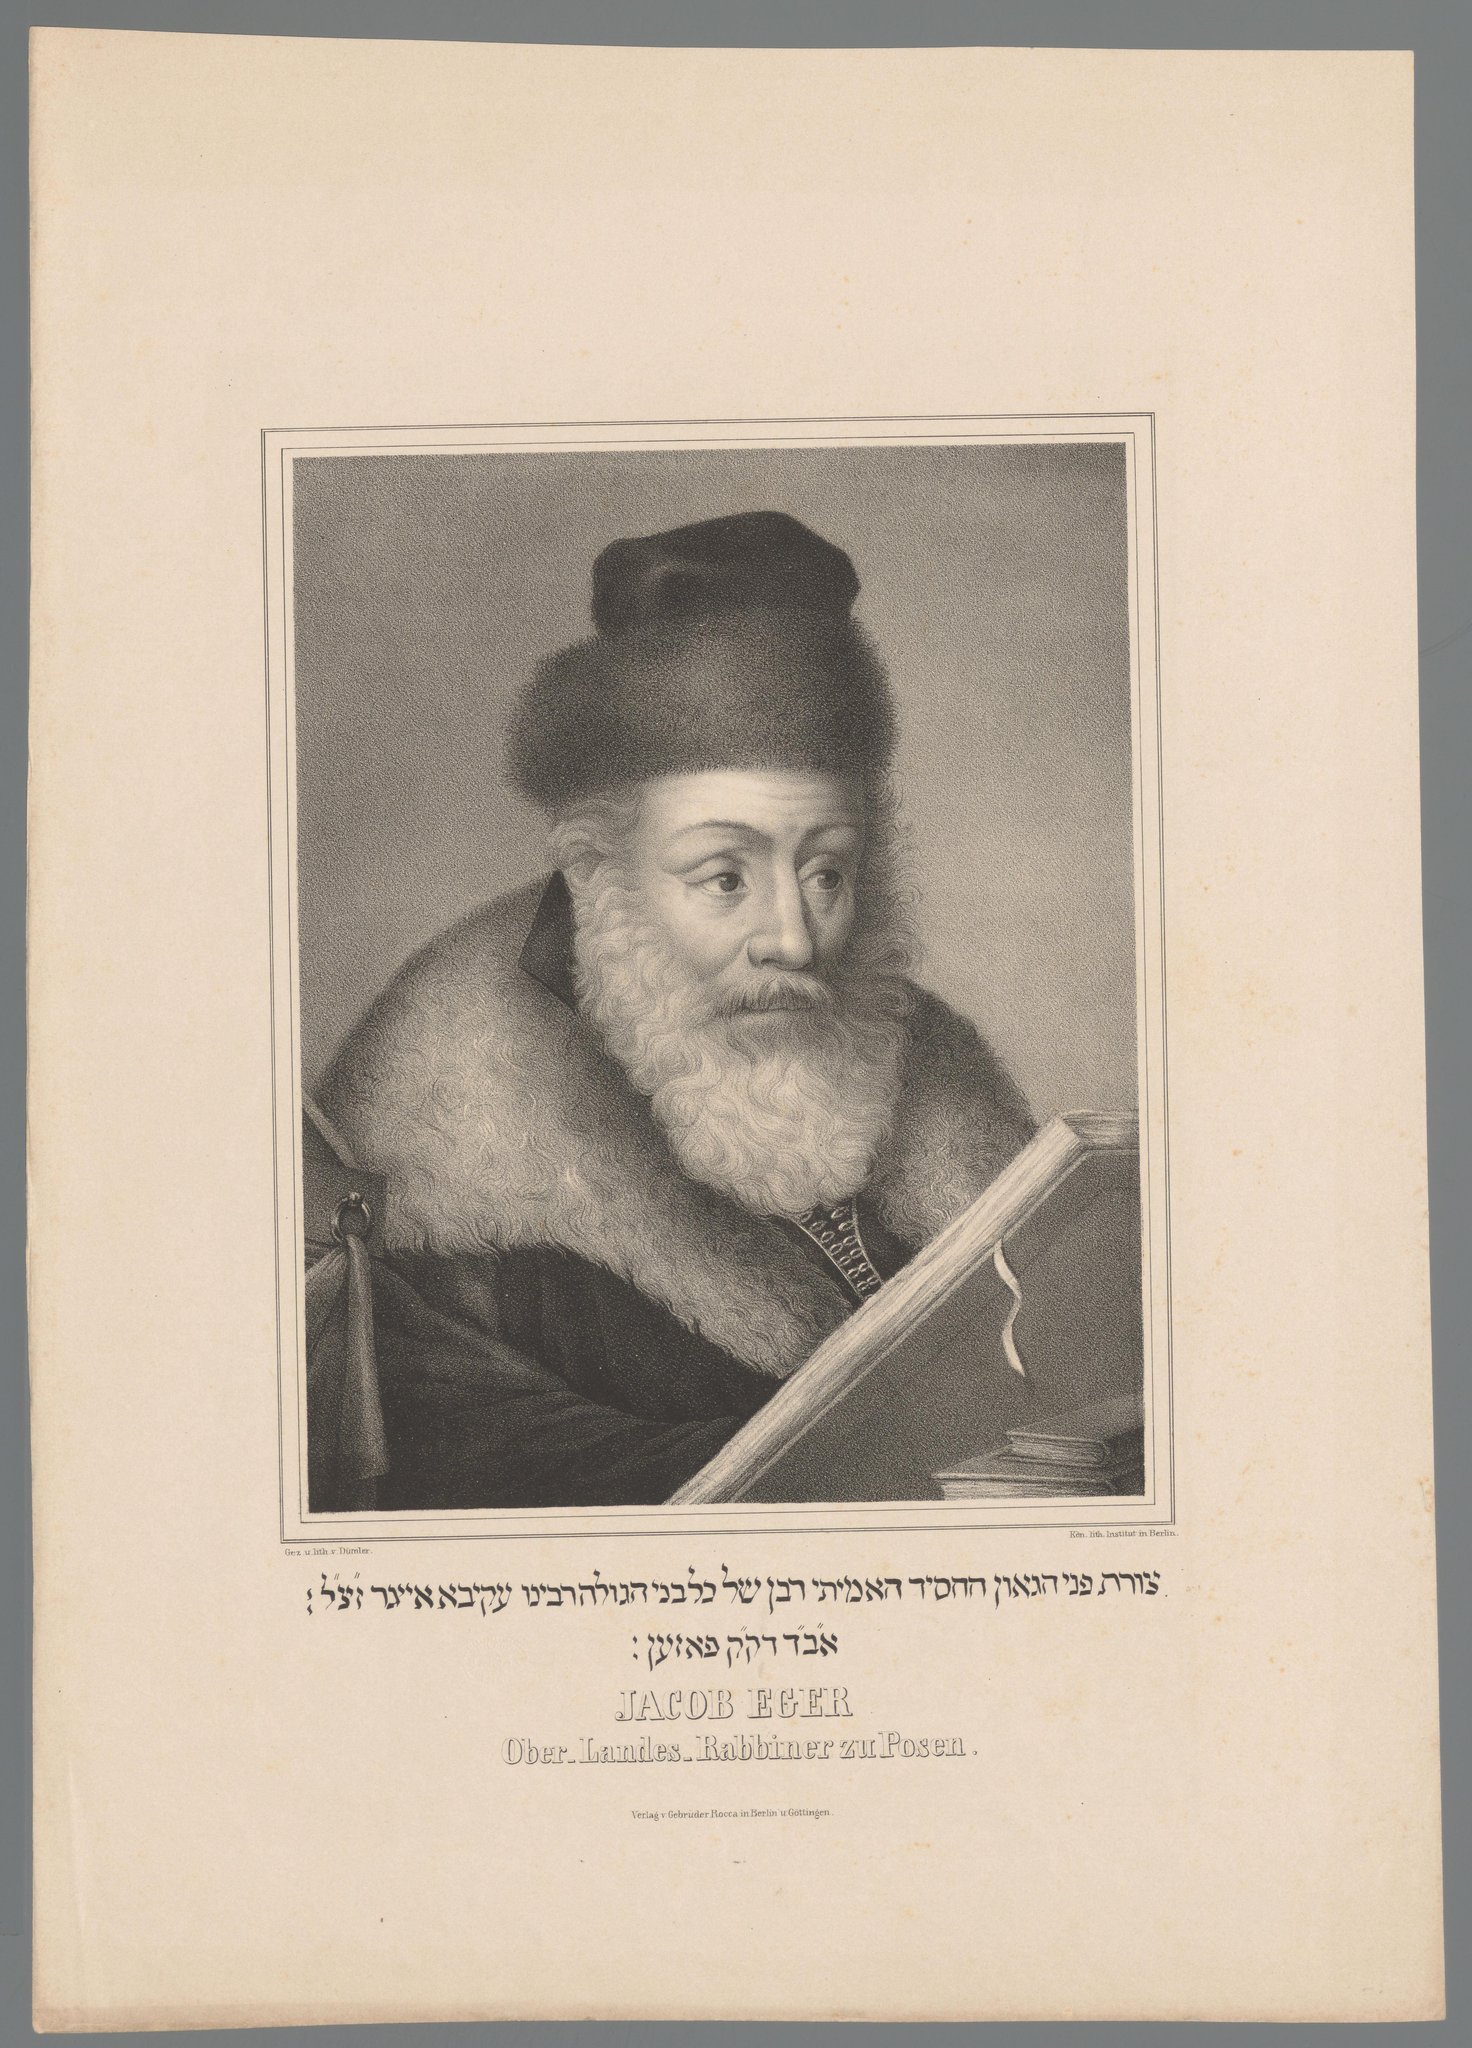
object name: print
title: Portret van Akiva Eger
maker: wilhelm dümler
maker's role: print maker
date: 1830-1899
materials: paper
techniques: lithograph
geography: berlin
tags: historical persons, beard, rabbi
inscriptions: collector's mark: Lugt 2228